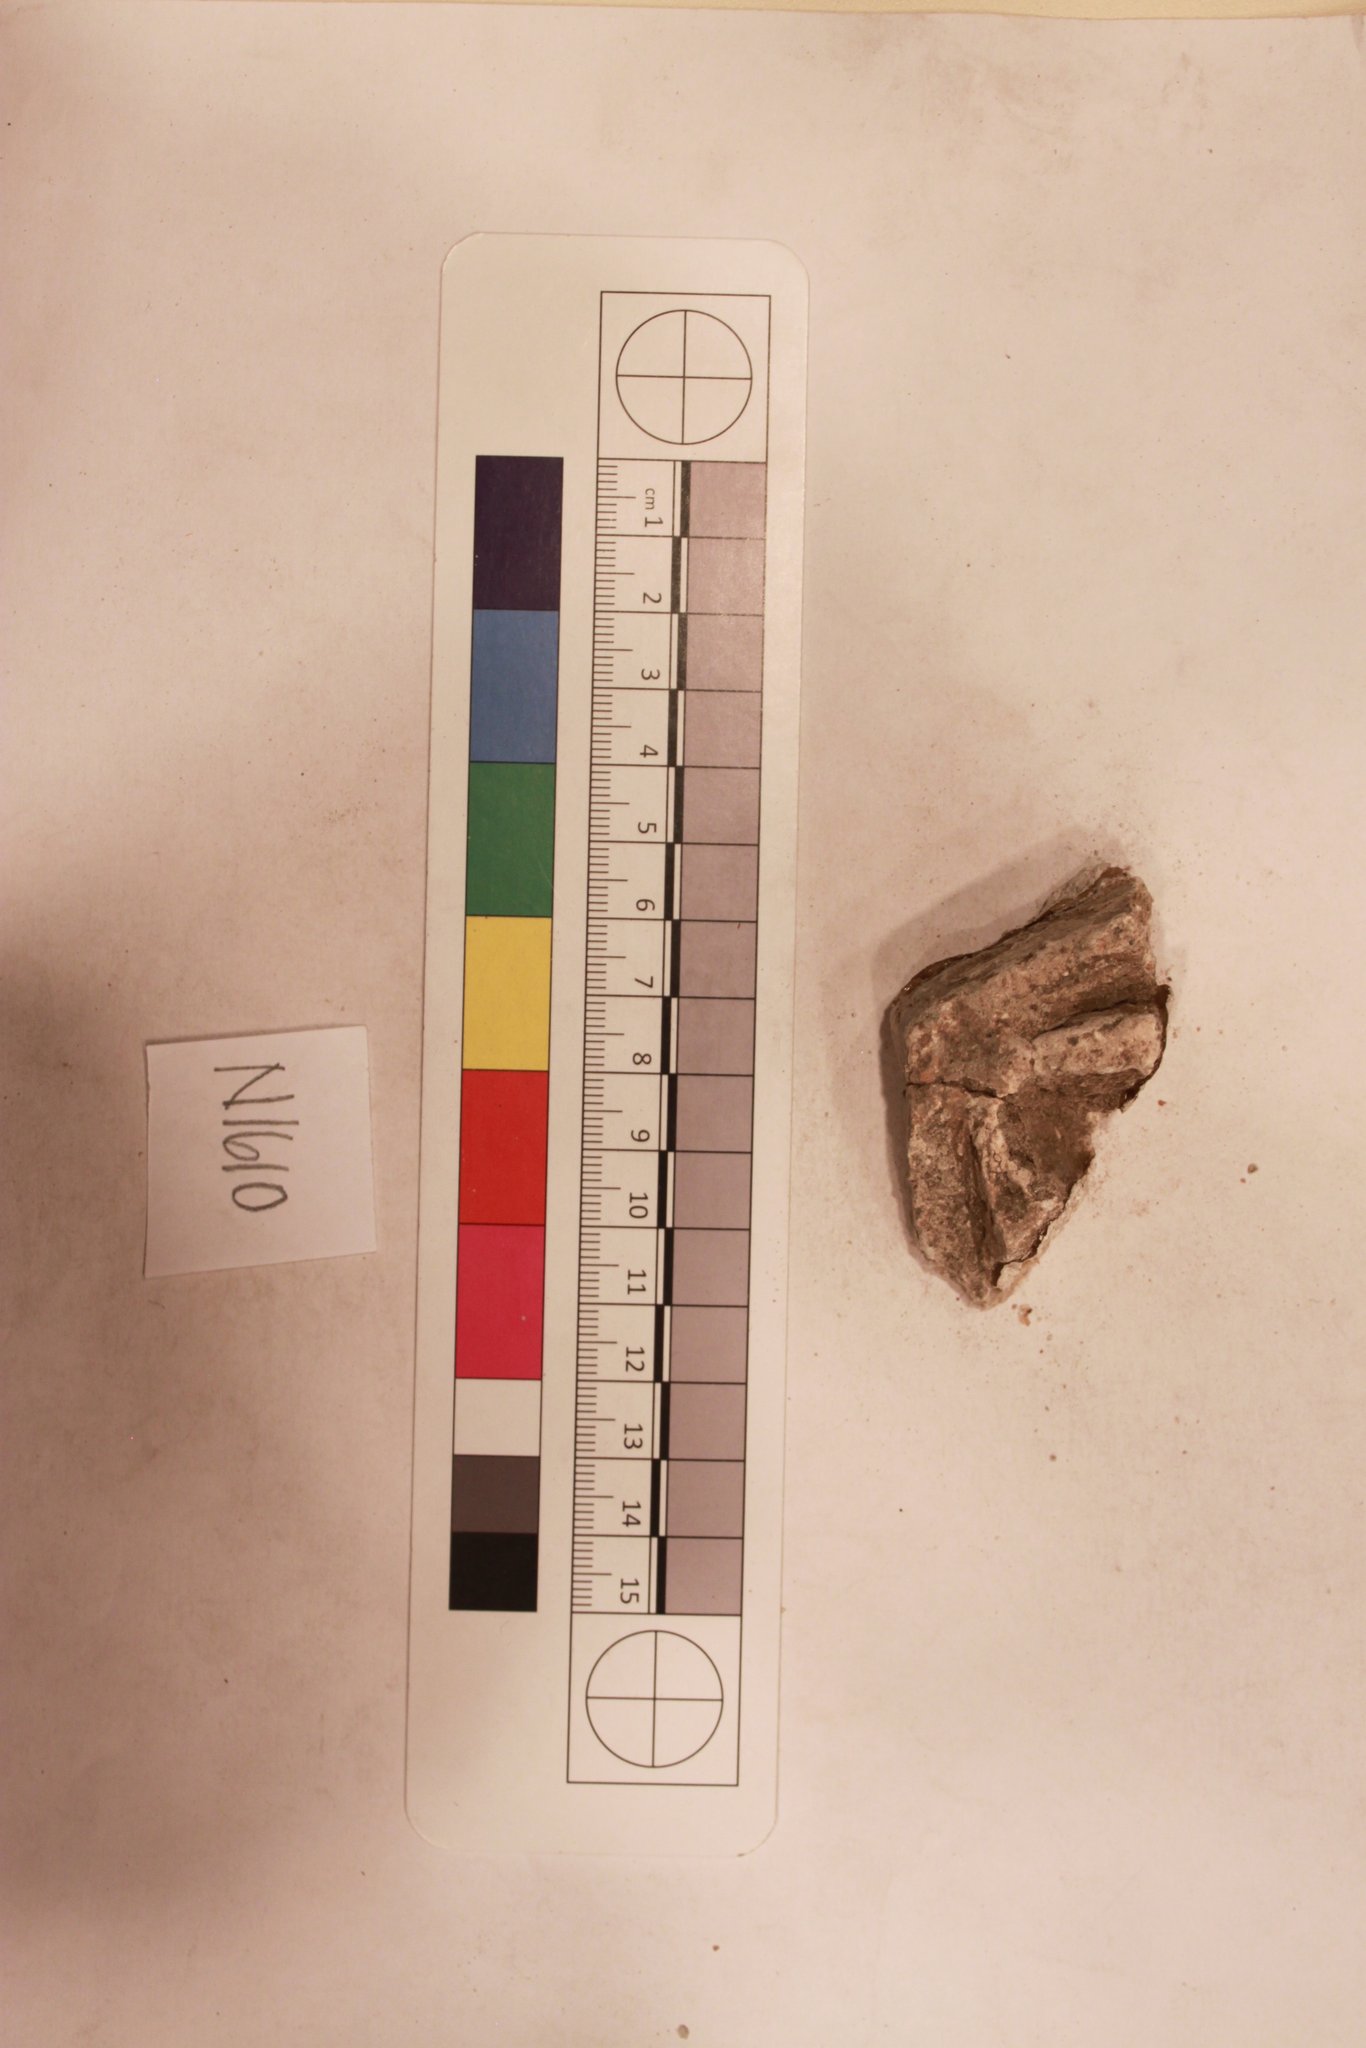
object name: fragment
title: Stucco Fragment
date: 701-1200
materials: plaster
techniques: carving, painting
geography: iran